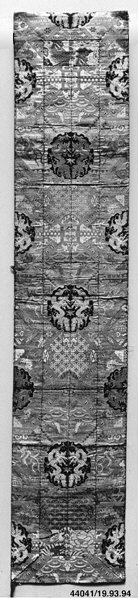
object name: stole, priest's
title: Priest's Stole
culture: japanese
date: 1673-1681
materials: metal thread, silk